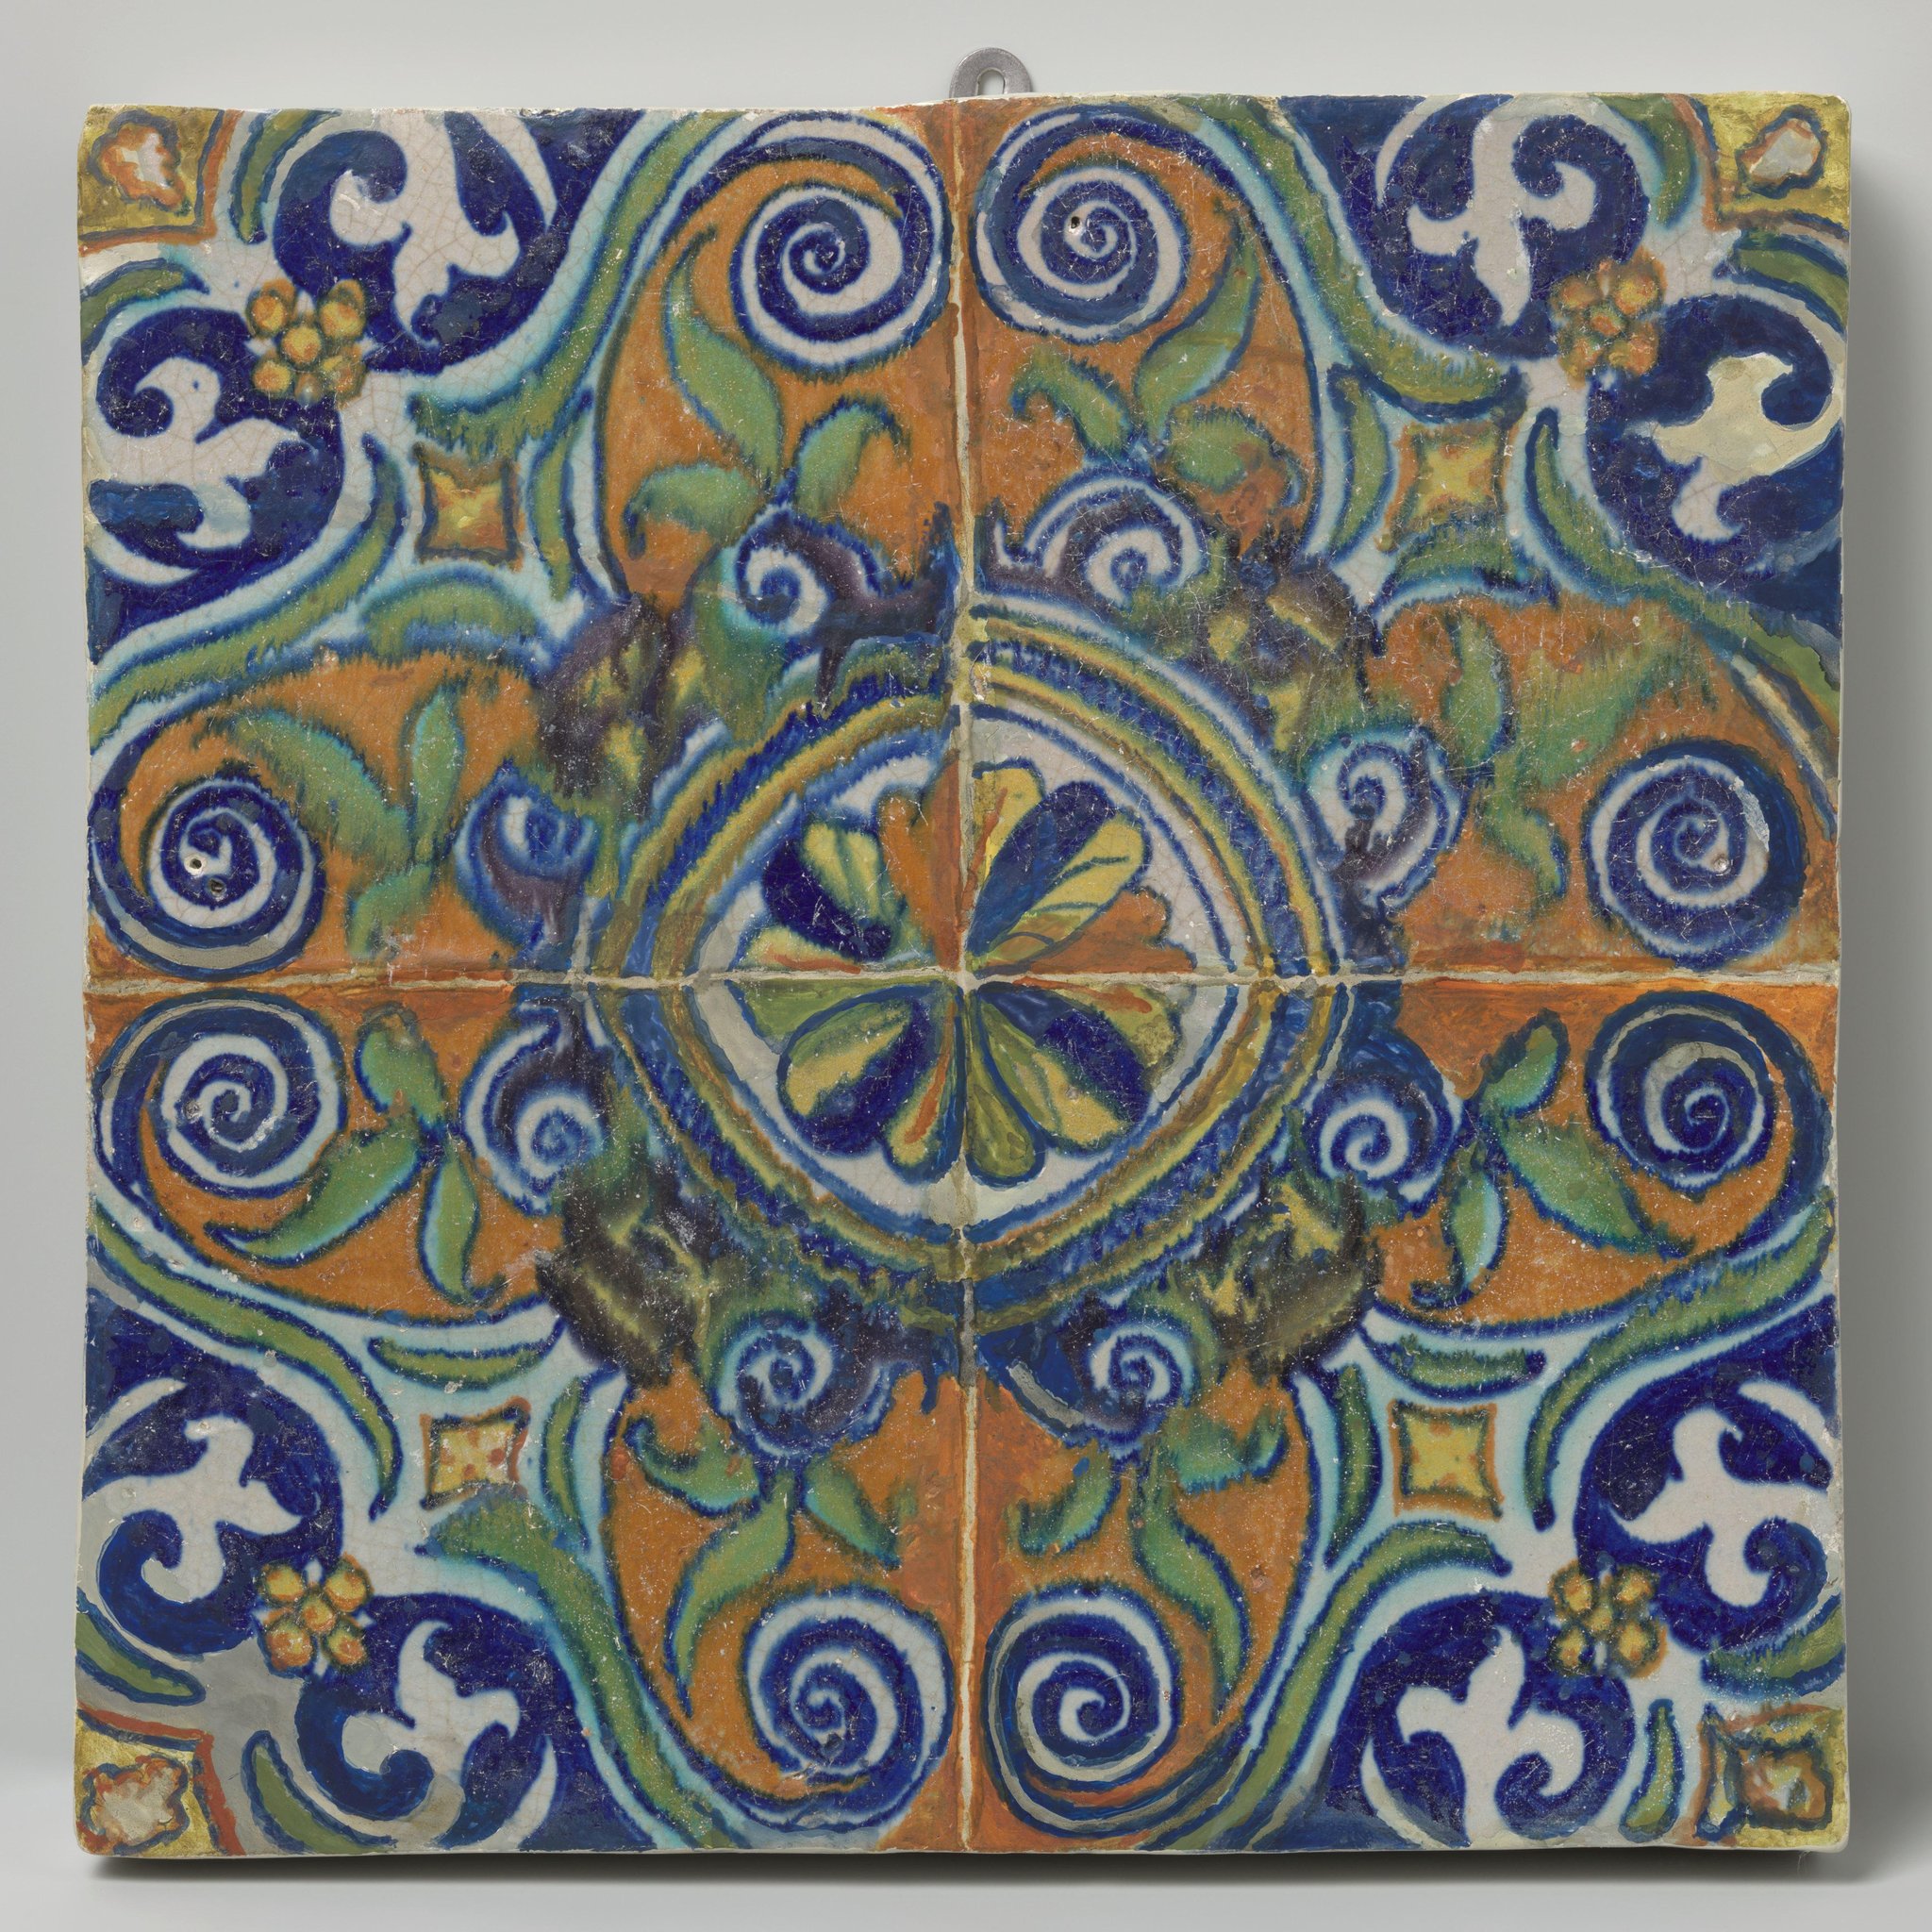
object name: tegelveld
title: Veld van vier tegels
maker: Anonymous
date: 1580-1600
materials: earthenware, glaze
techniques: maiolica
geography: antwerp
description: Veld van 4 tegels (2 x 2) elk met een veelkleurig (blauw, oranje, geel, groen en paars) ornament van een rozet omgeven door voluten.